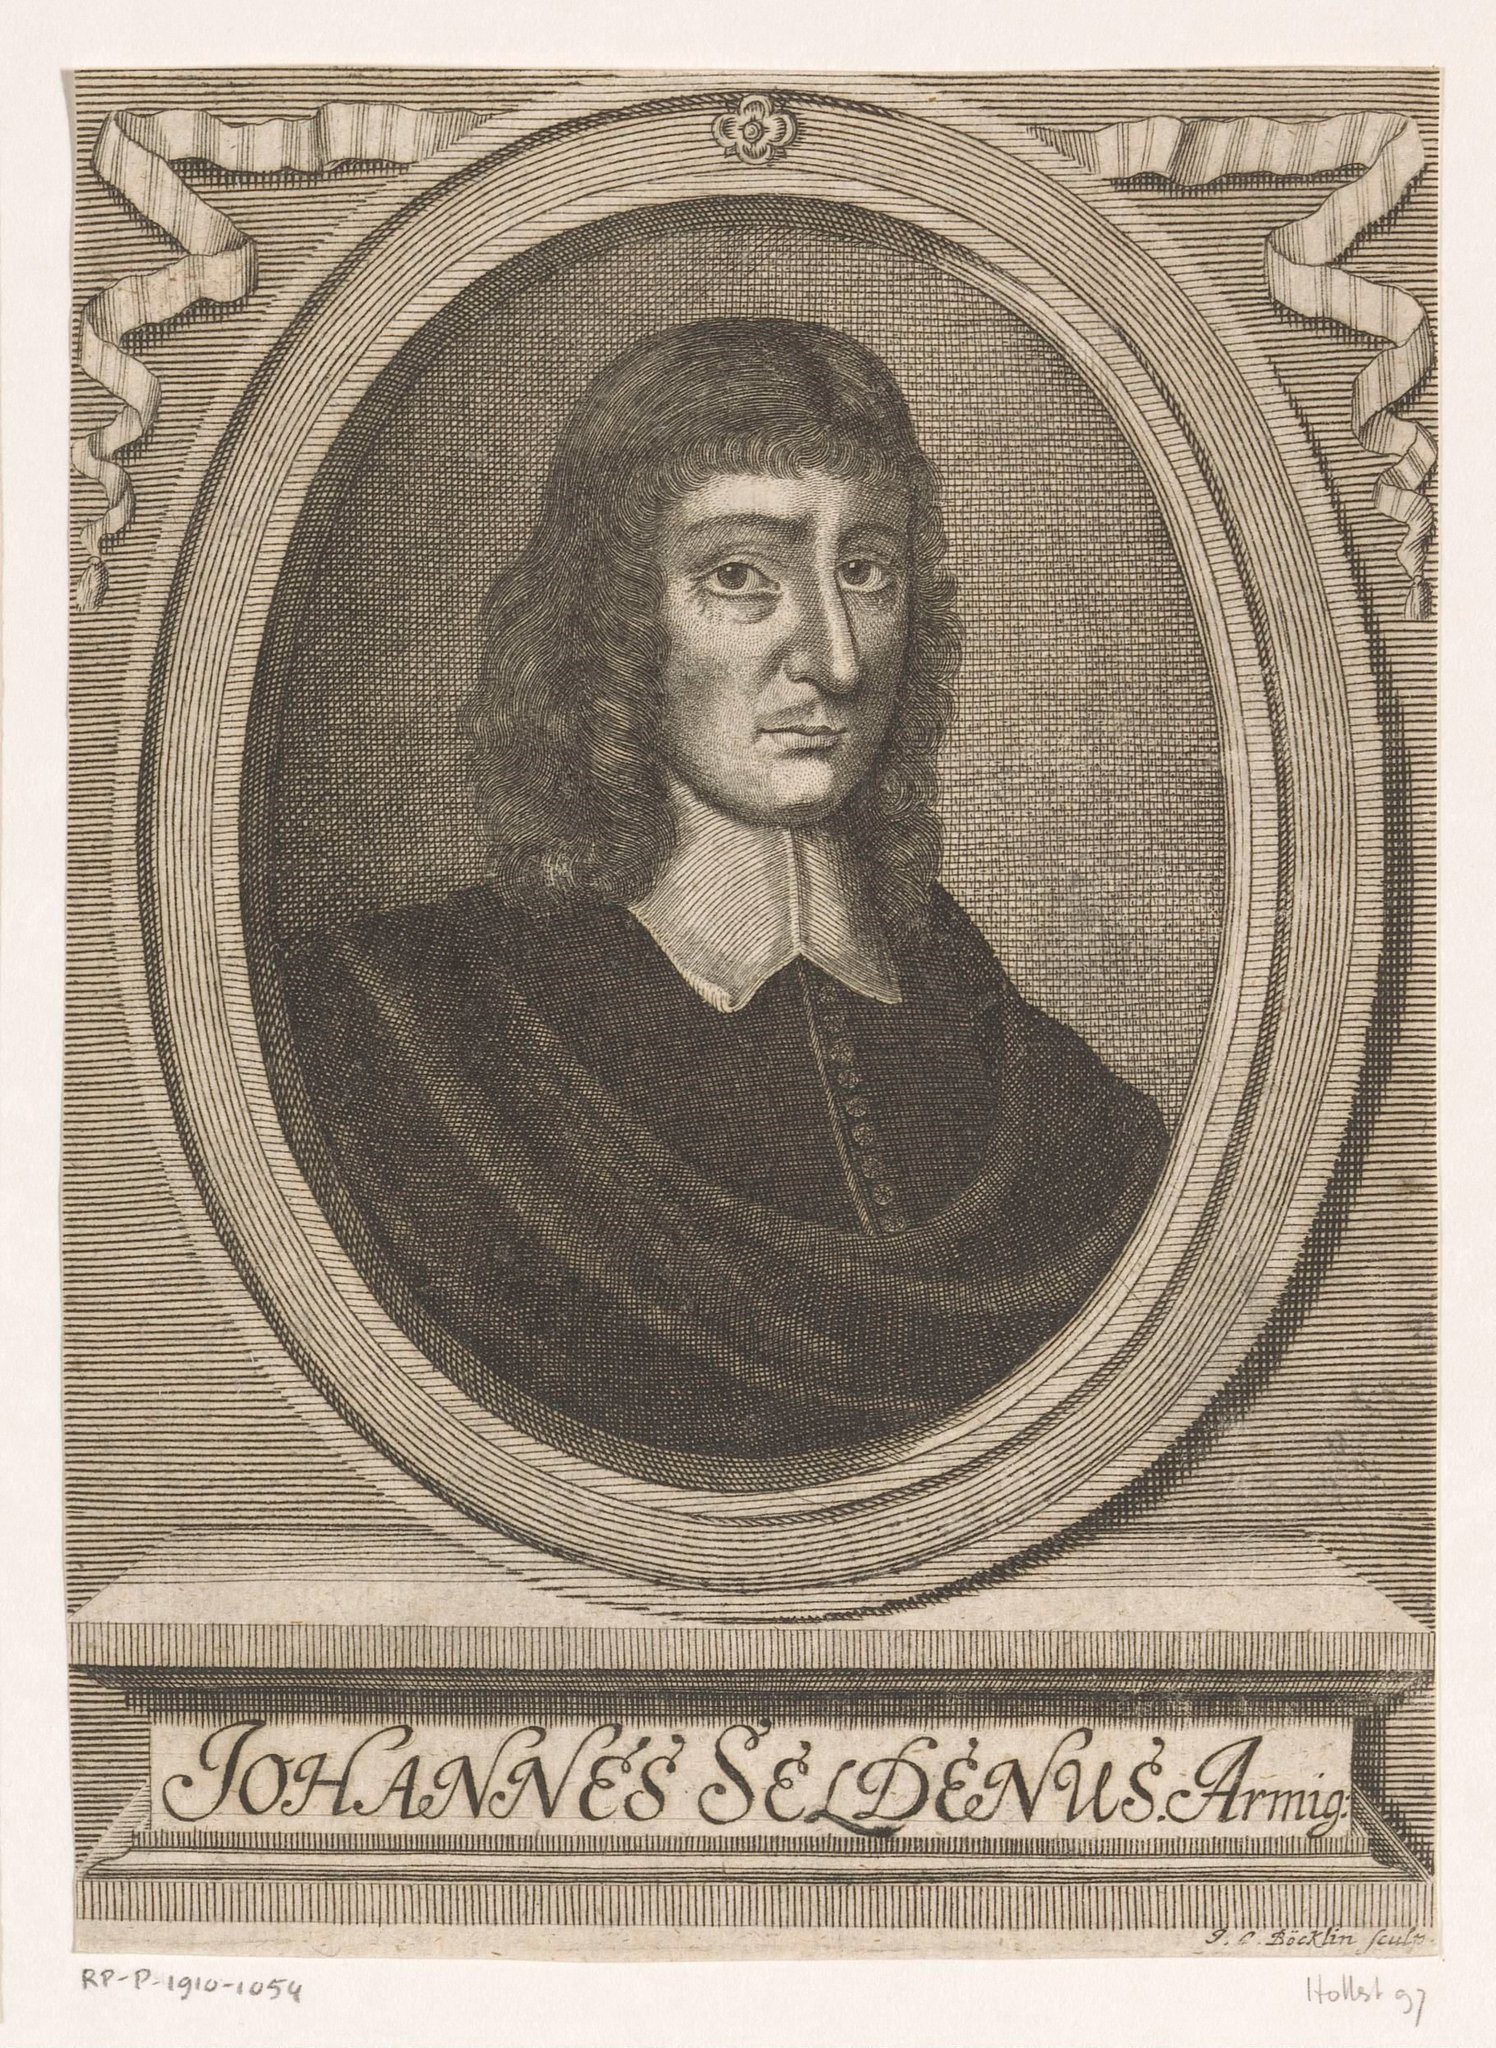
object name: print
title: Portret van John Selden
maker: johann christoph boecklin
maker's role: print maker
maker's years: 1657-1709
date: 1696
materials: paper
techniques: engraving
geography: leipzig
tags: historical persons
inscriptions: collector's mark: Lugt 2228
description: Prent ook gebruikt in: Selden, John. Tituli Honorum [uit het Latijn vertaald door:] Simon Johannes Arnold. Frankfurt an der Oder: Jeremias Schrey en erven Heinrich Johann Meyer, 1696.